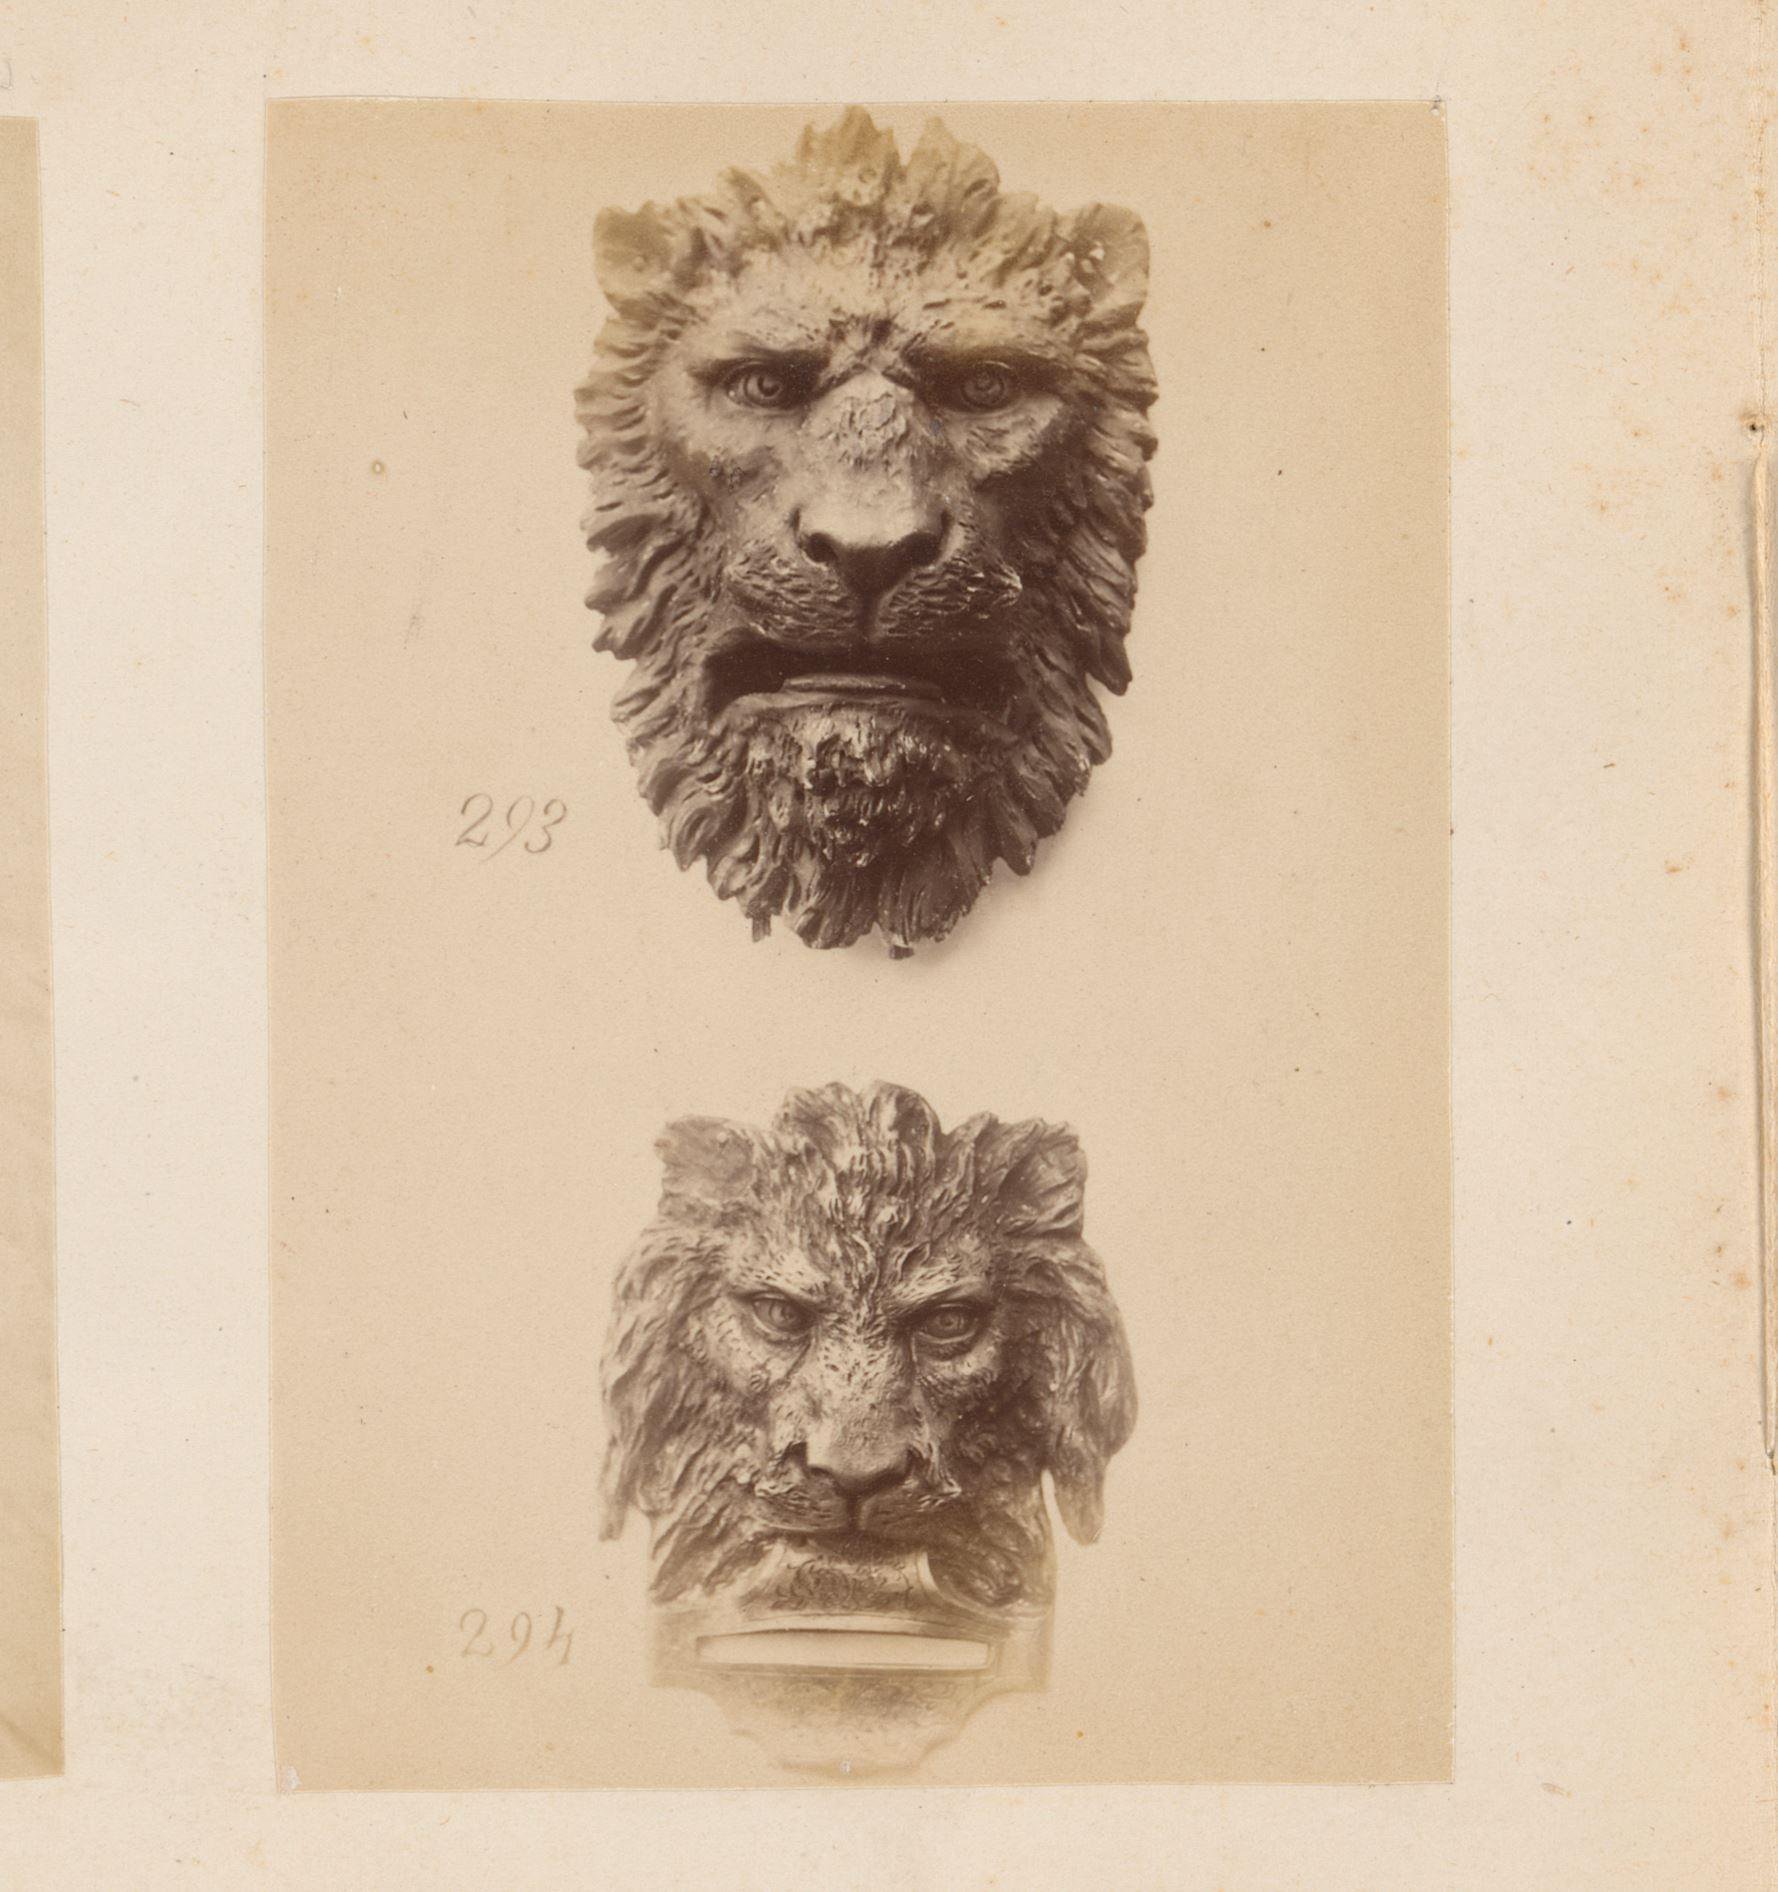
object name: page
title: Twee metalen leeuwenkoppen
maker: Anonymous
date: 1860-1885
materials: photographic support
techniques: albumen print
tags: lion's head ~ ornament